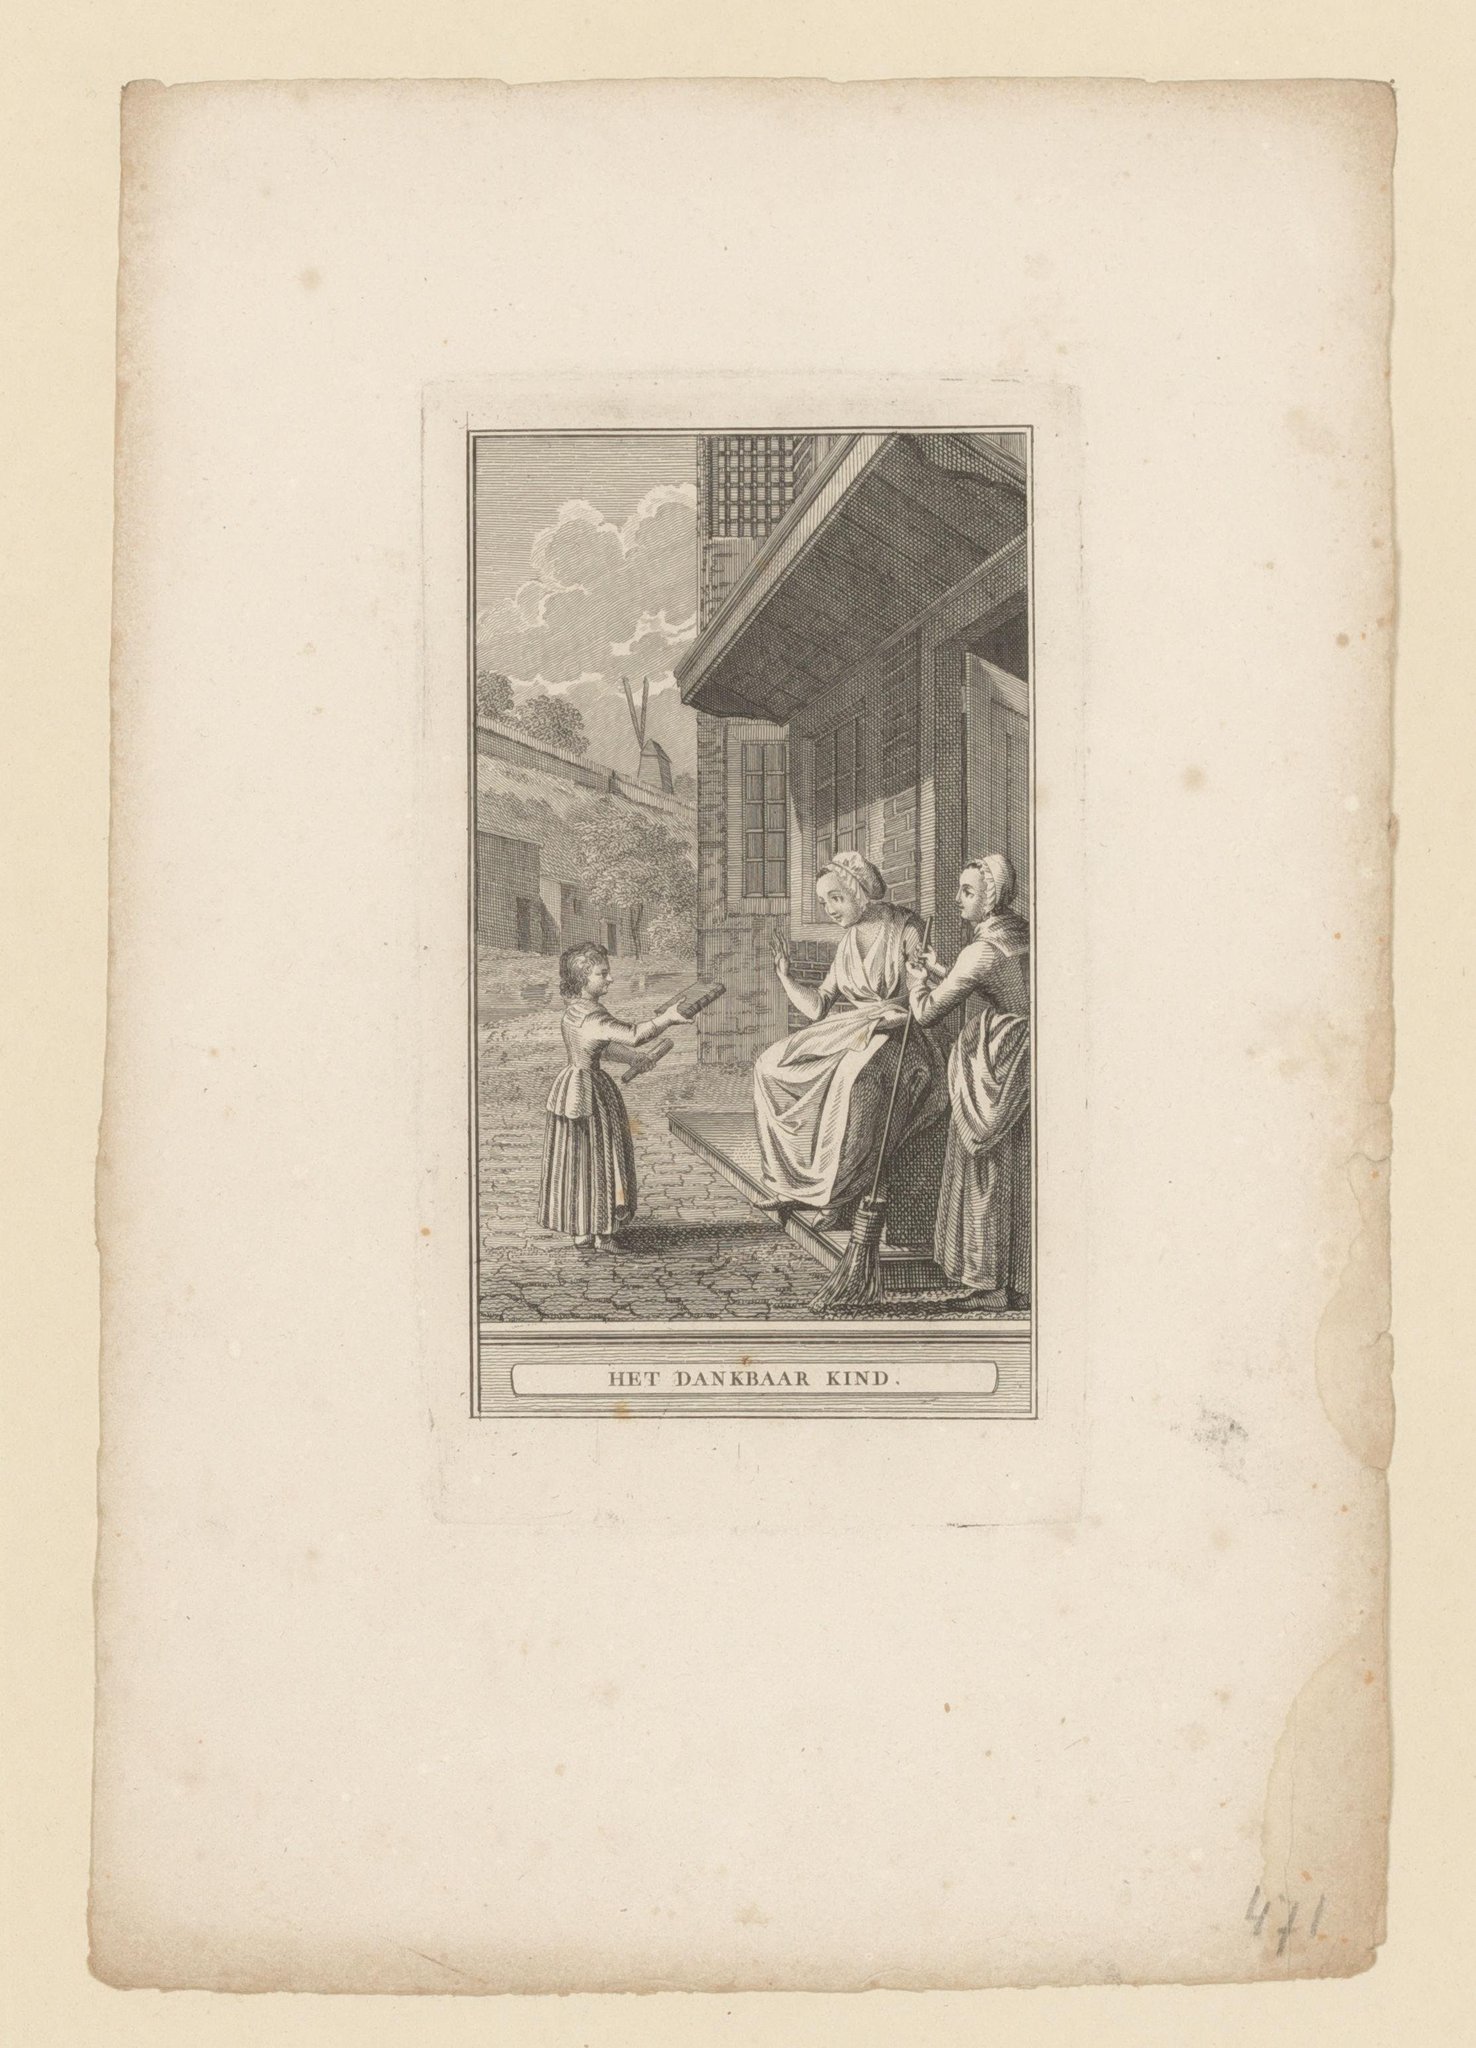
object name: print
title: Het dankbaar kind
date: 1792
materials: paper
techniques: etching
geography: the hague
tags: book, mother and child(ren), woman and child(ren) (family group)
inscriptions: collector's mark: Lugt 1641, stamp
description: Onderwerpsrubrieken binnen de Atlas Zeden en Gewoonten: Zeden en Gewoonten in Engeren Zin, Des menschen beging, midden en einde, Kinderleven – Kinderspel en Kinderprenten.